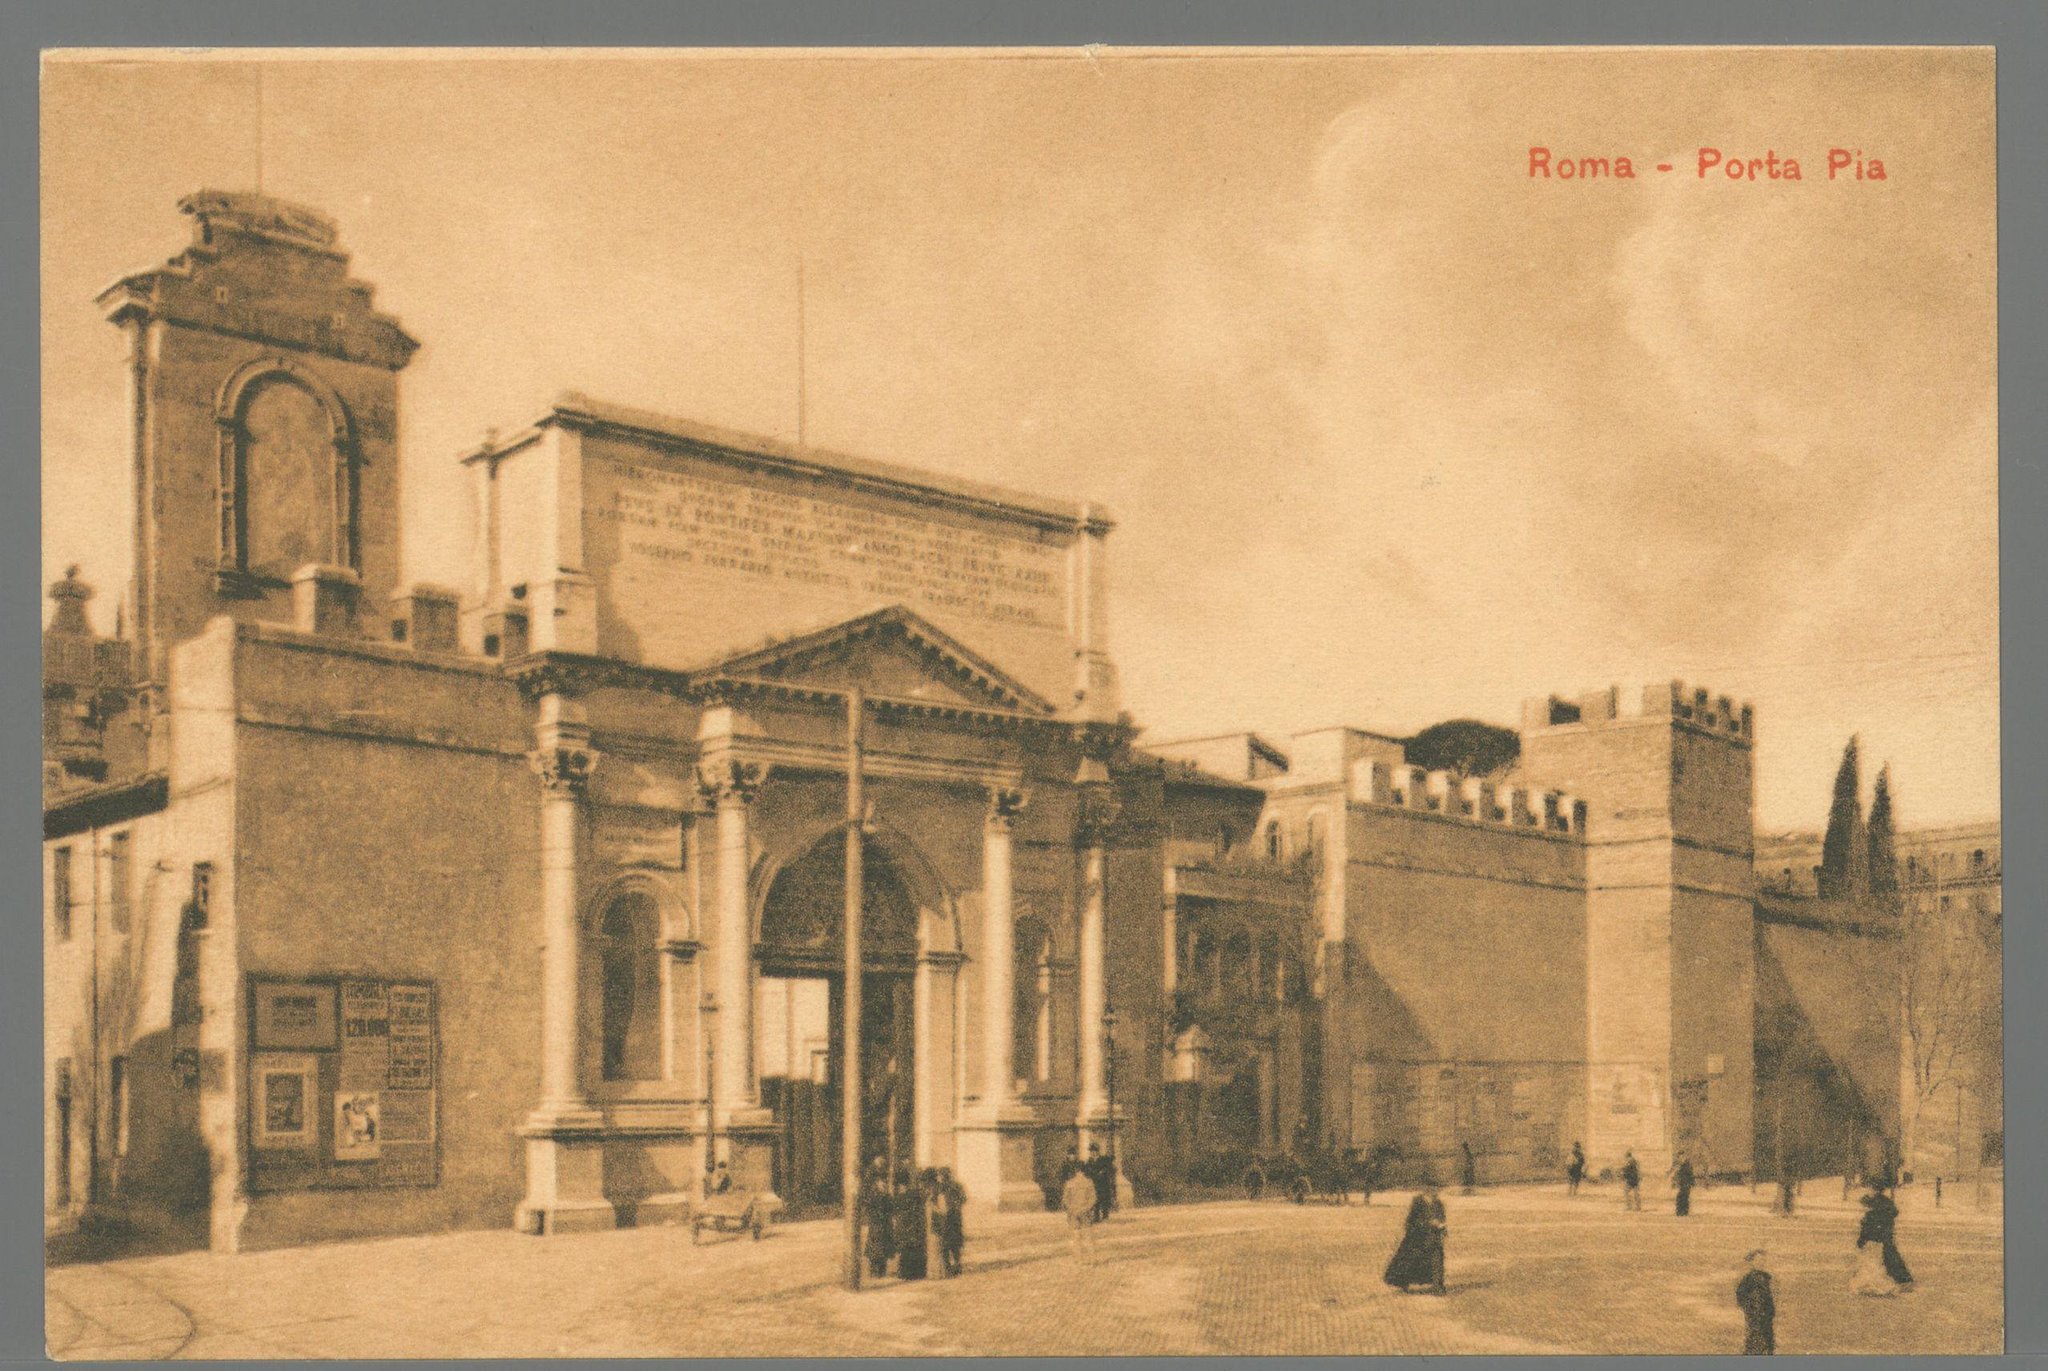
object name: photomechanical print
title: Roma. Porta Pia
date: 1906-1920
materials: cardboard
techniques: photograph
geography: rome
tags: city-gate, square, place, circus, etc. (+ city(-scape) with figures, staffage)